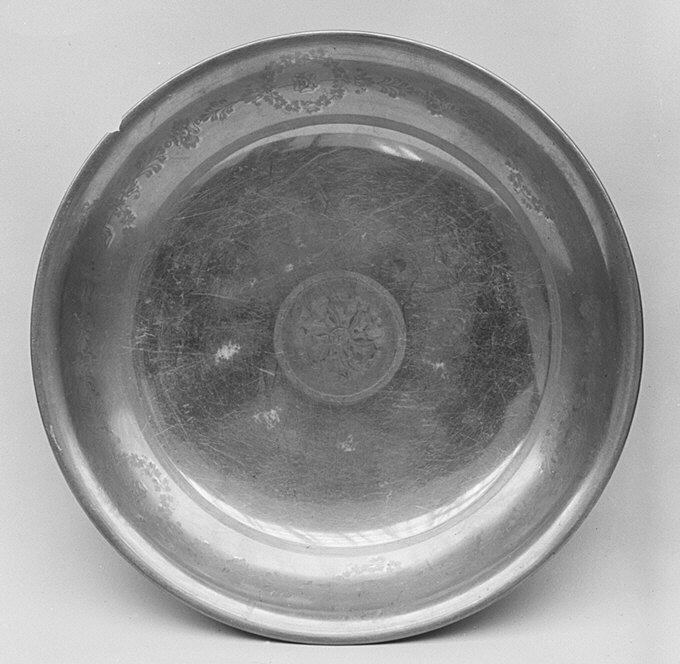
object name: saucer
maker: imperial porcelain manufactory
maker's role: manufactory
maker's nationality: austrian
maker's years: 1744-1864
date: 1818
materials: hard paste porcelain